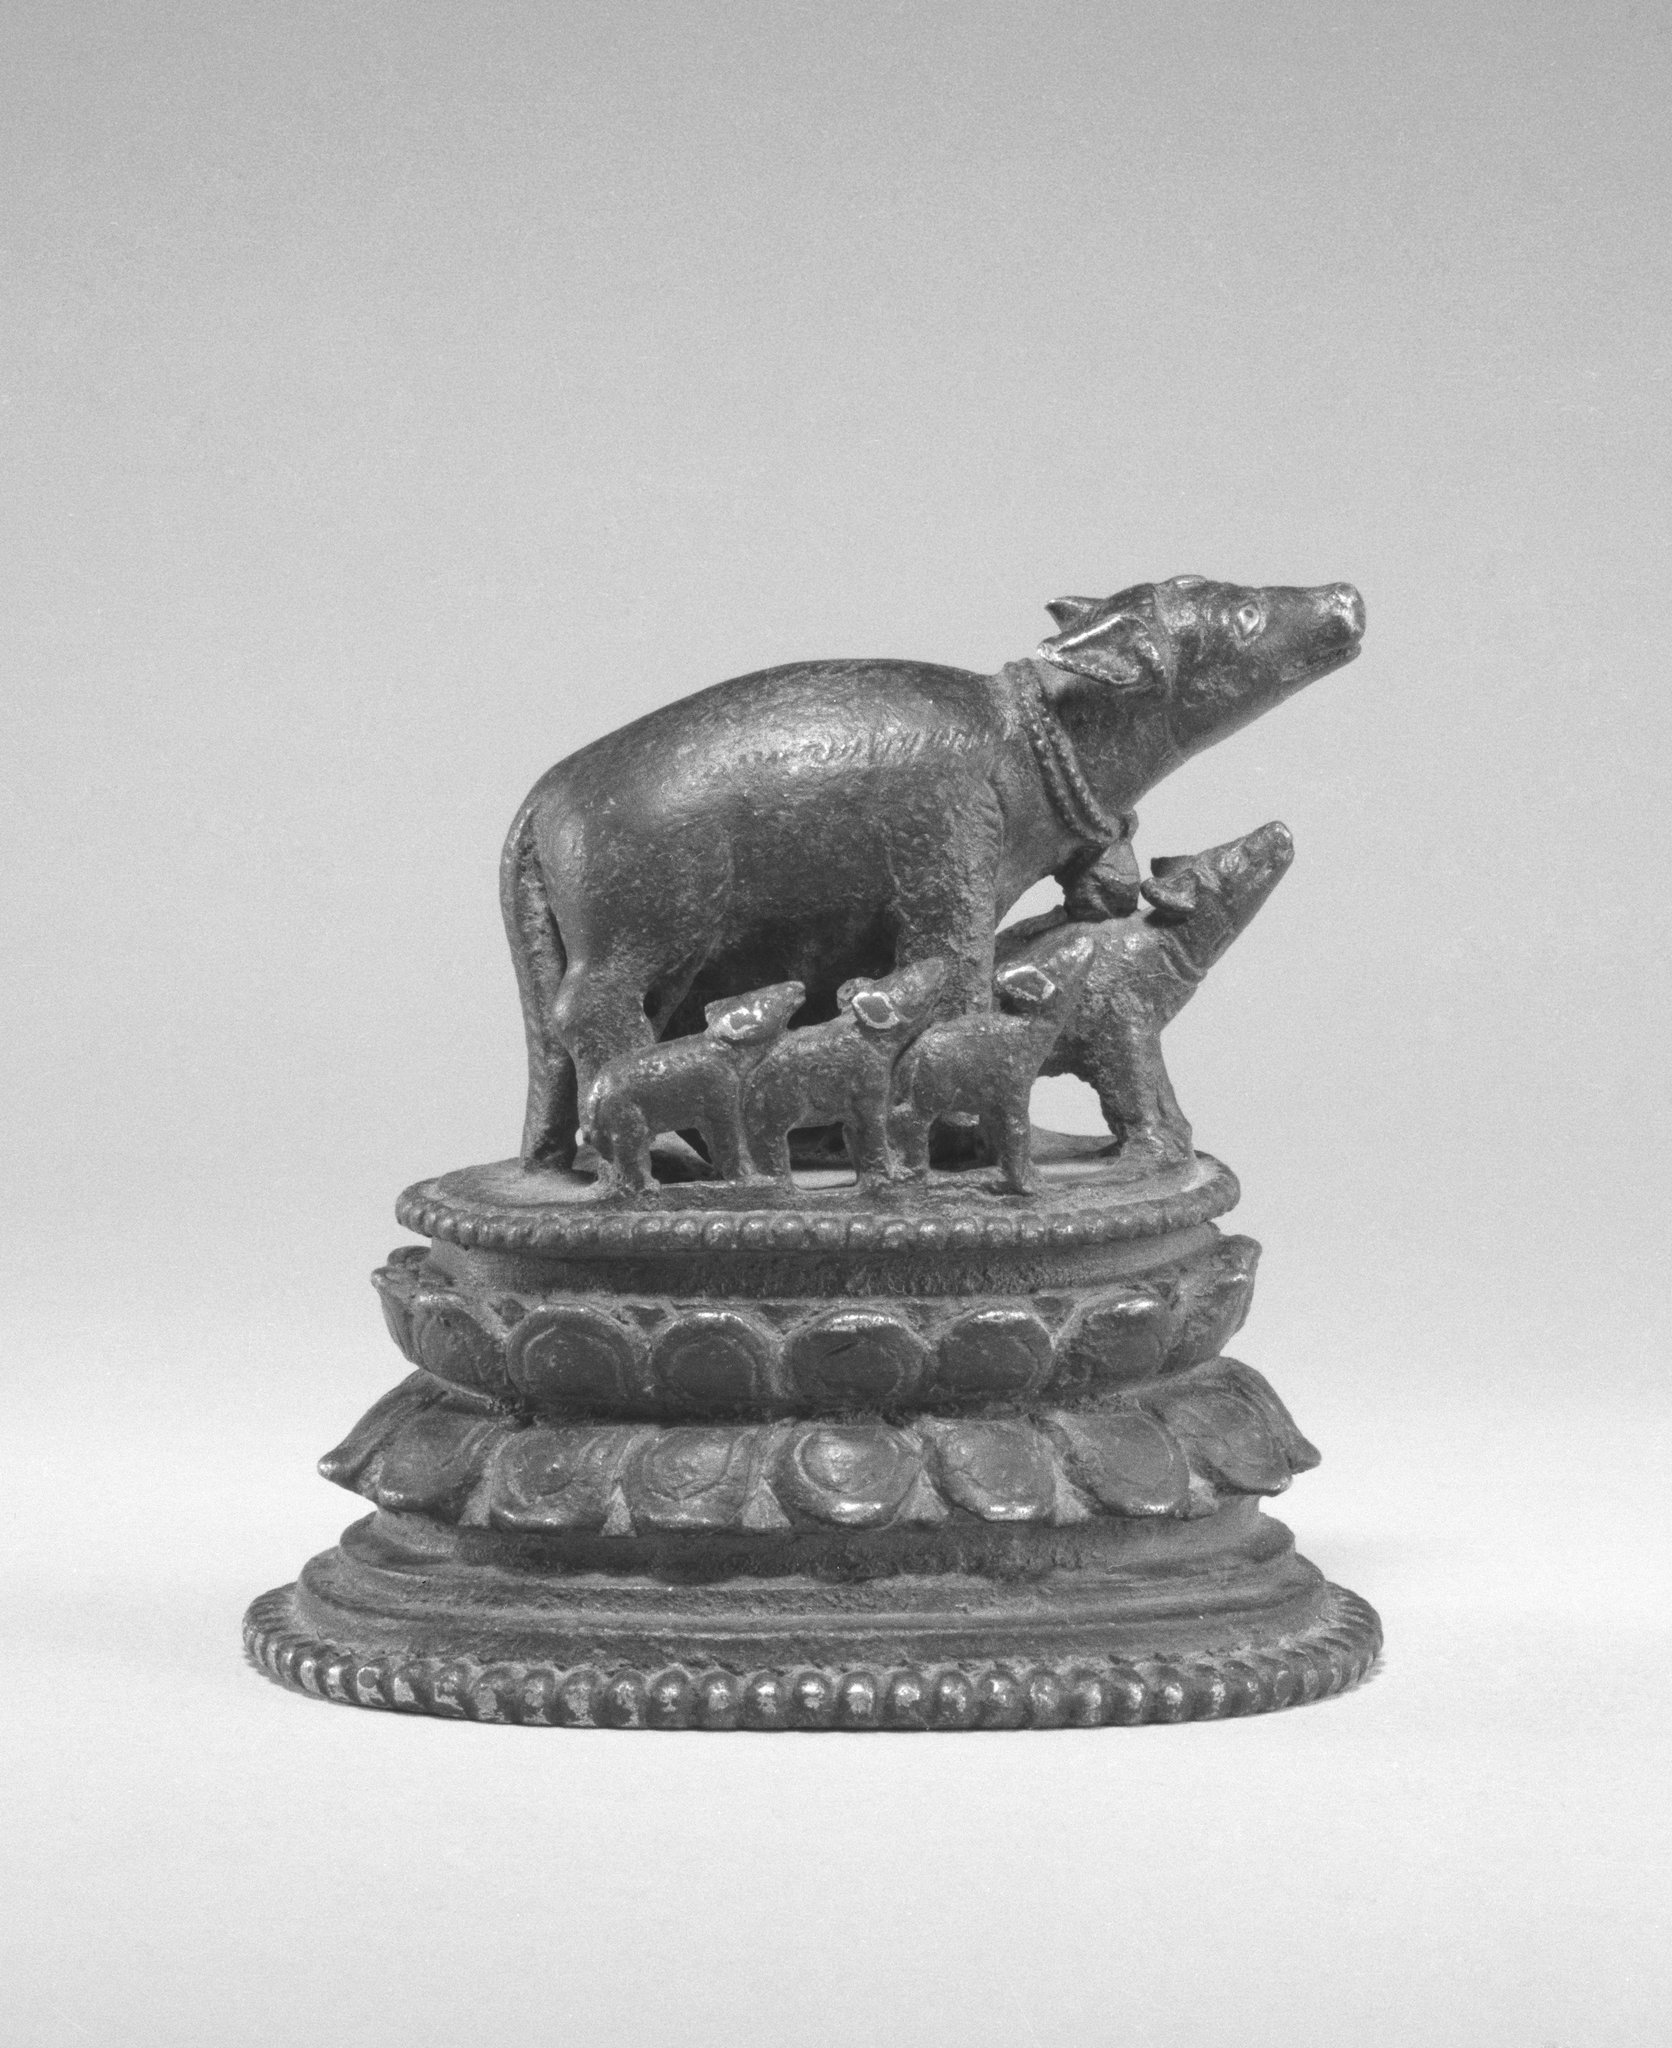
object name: figure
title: Marichi, the Goddess of Dawn, with Seven Pigs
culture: indian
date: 1001-1200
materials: bronze, silver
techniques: inlay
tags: pigs,lotuses